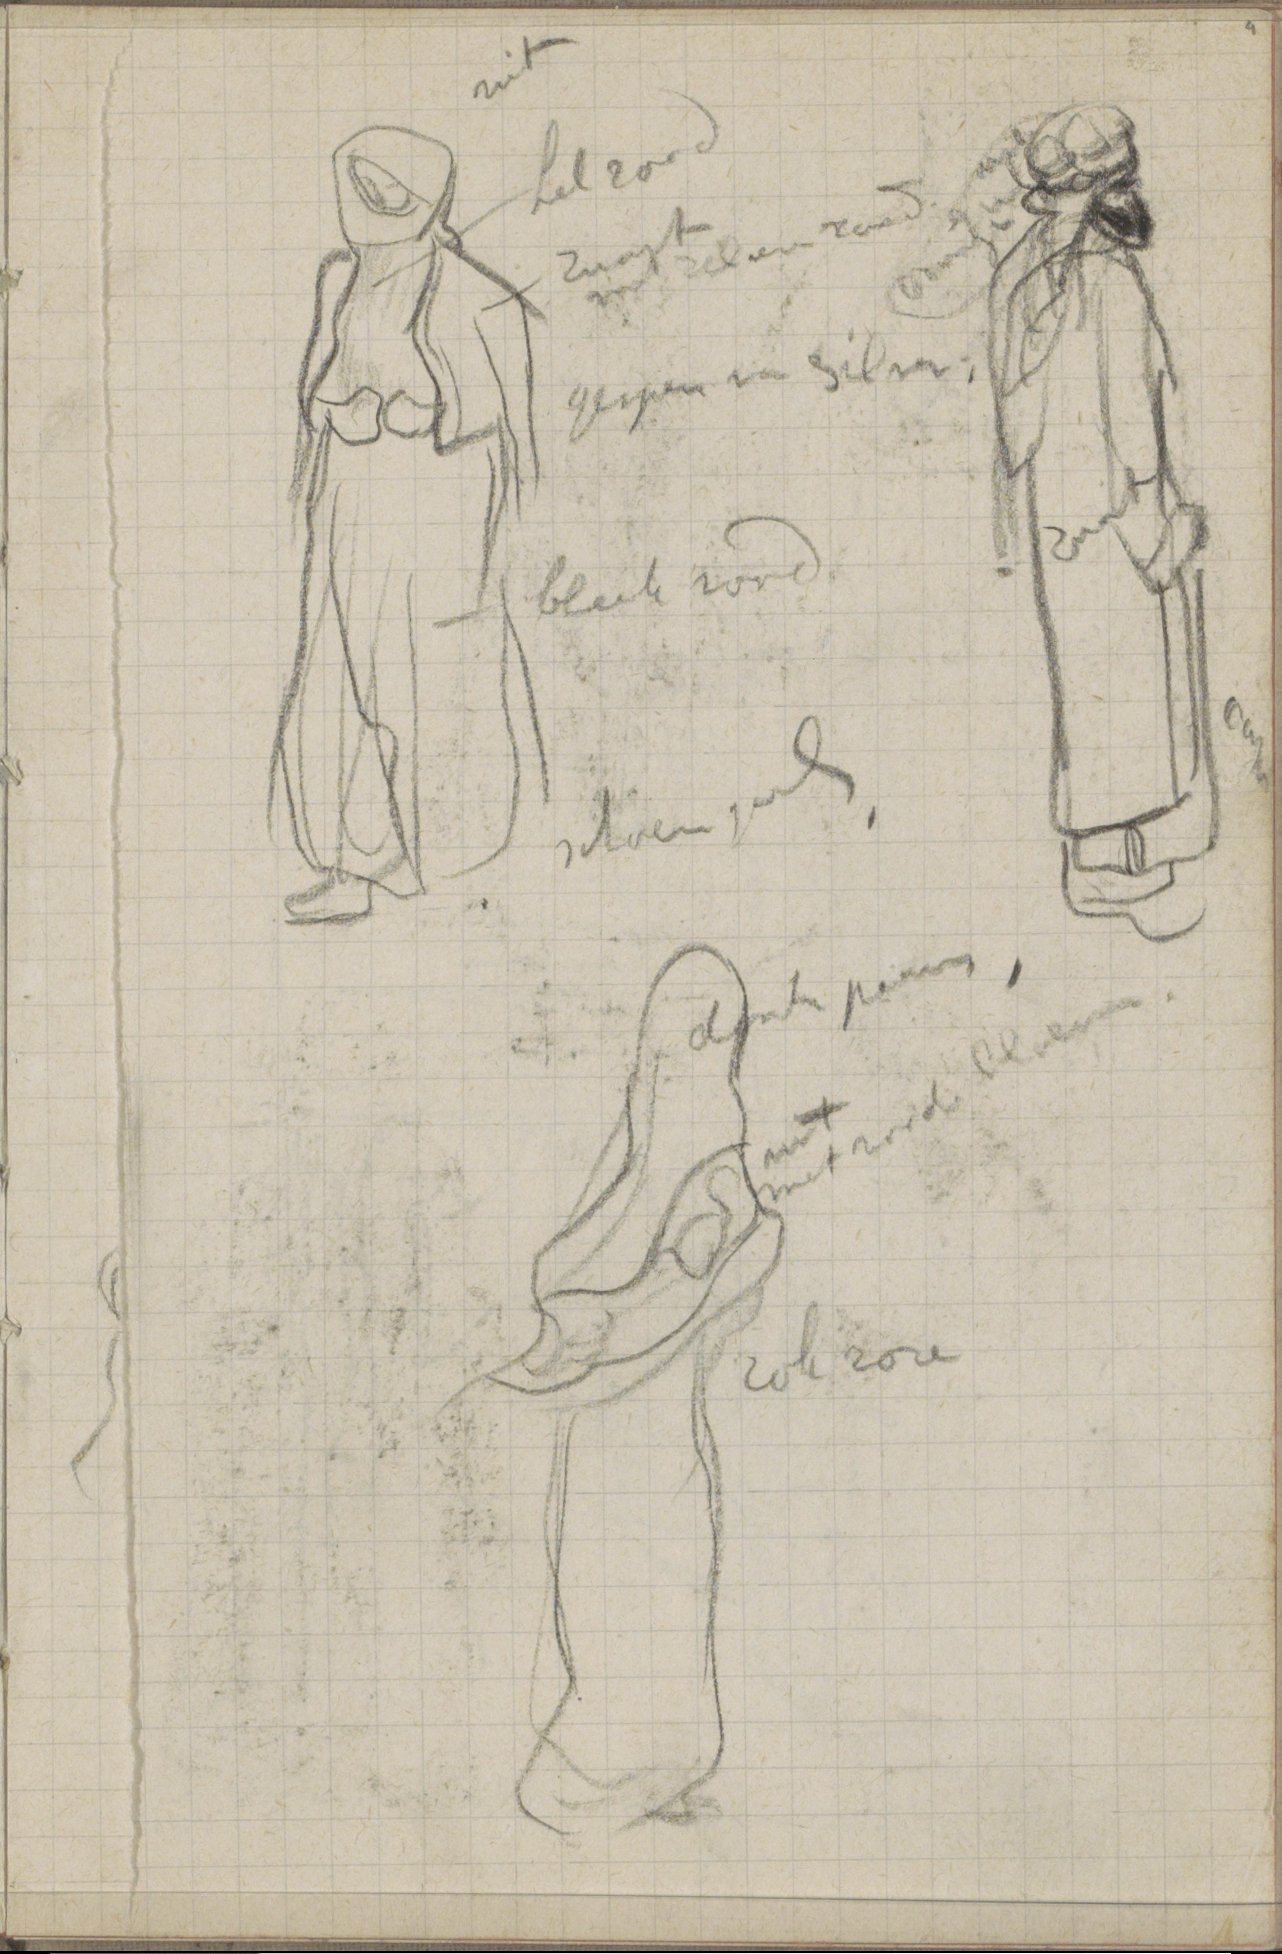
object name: sketchbook leaf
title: Drie staande figuren in oosterse kleding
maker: marius bauer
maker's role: draughtsman, print maker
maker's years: 1867-1932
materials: chalk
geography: istanbul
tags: asiatic races and peoples, head-gear, clothes, costume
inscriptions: kleurnotitie, handgeschreven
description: In verschillende aanzichten met hoofddeksels. Pagina 4 uit een schetsboek met 51 bladen.